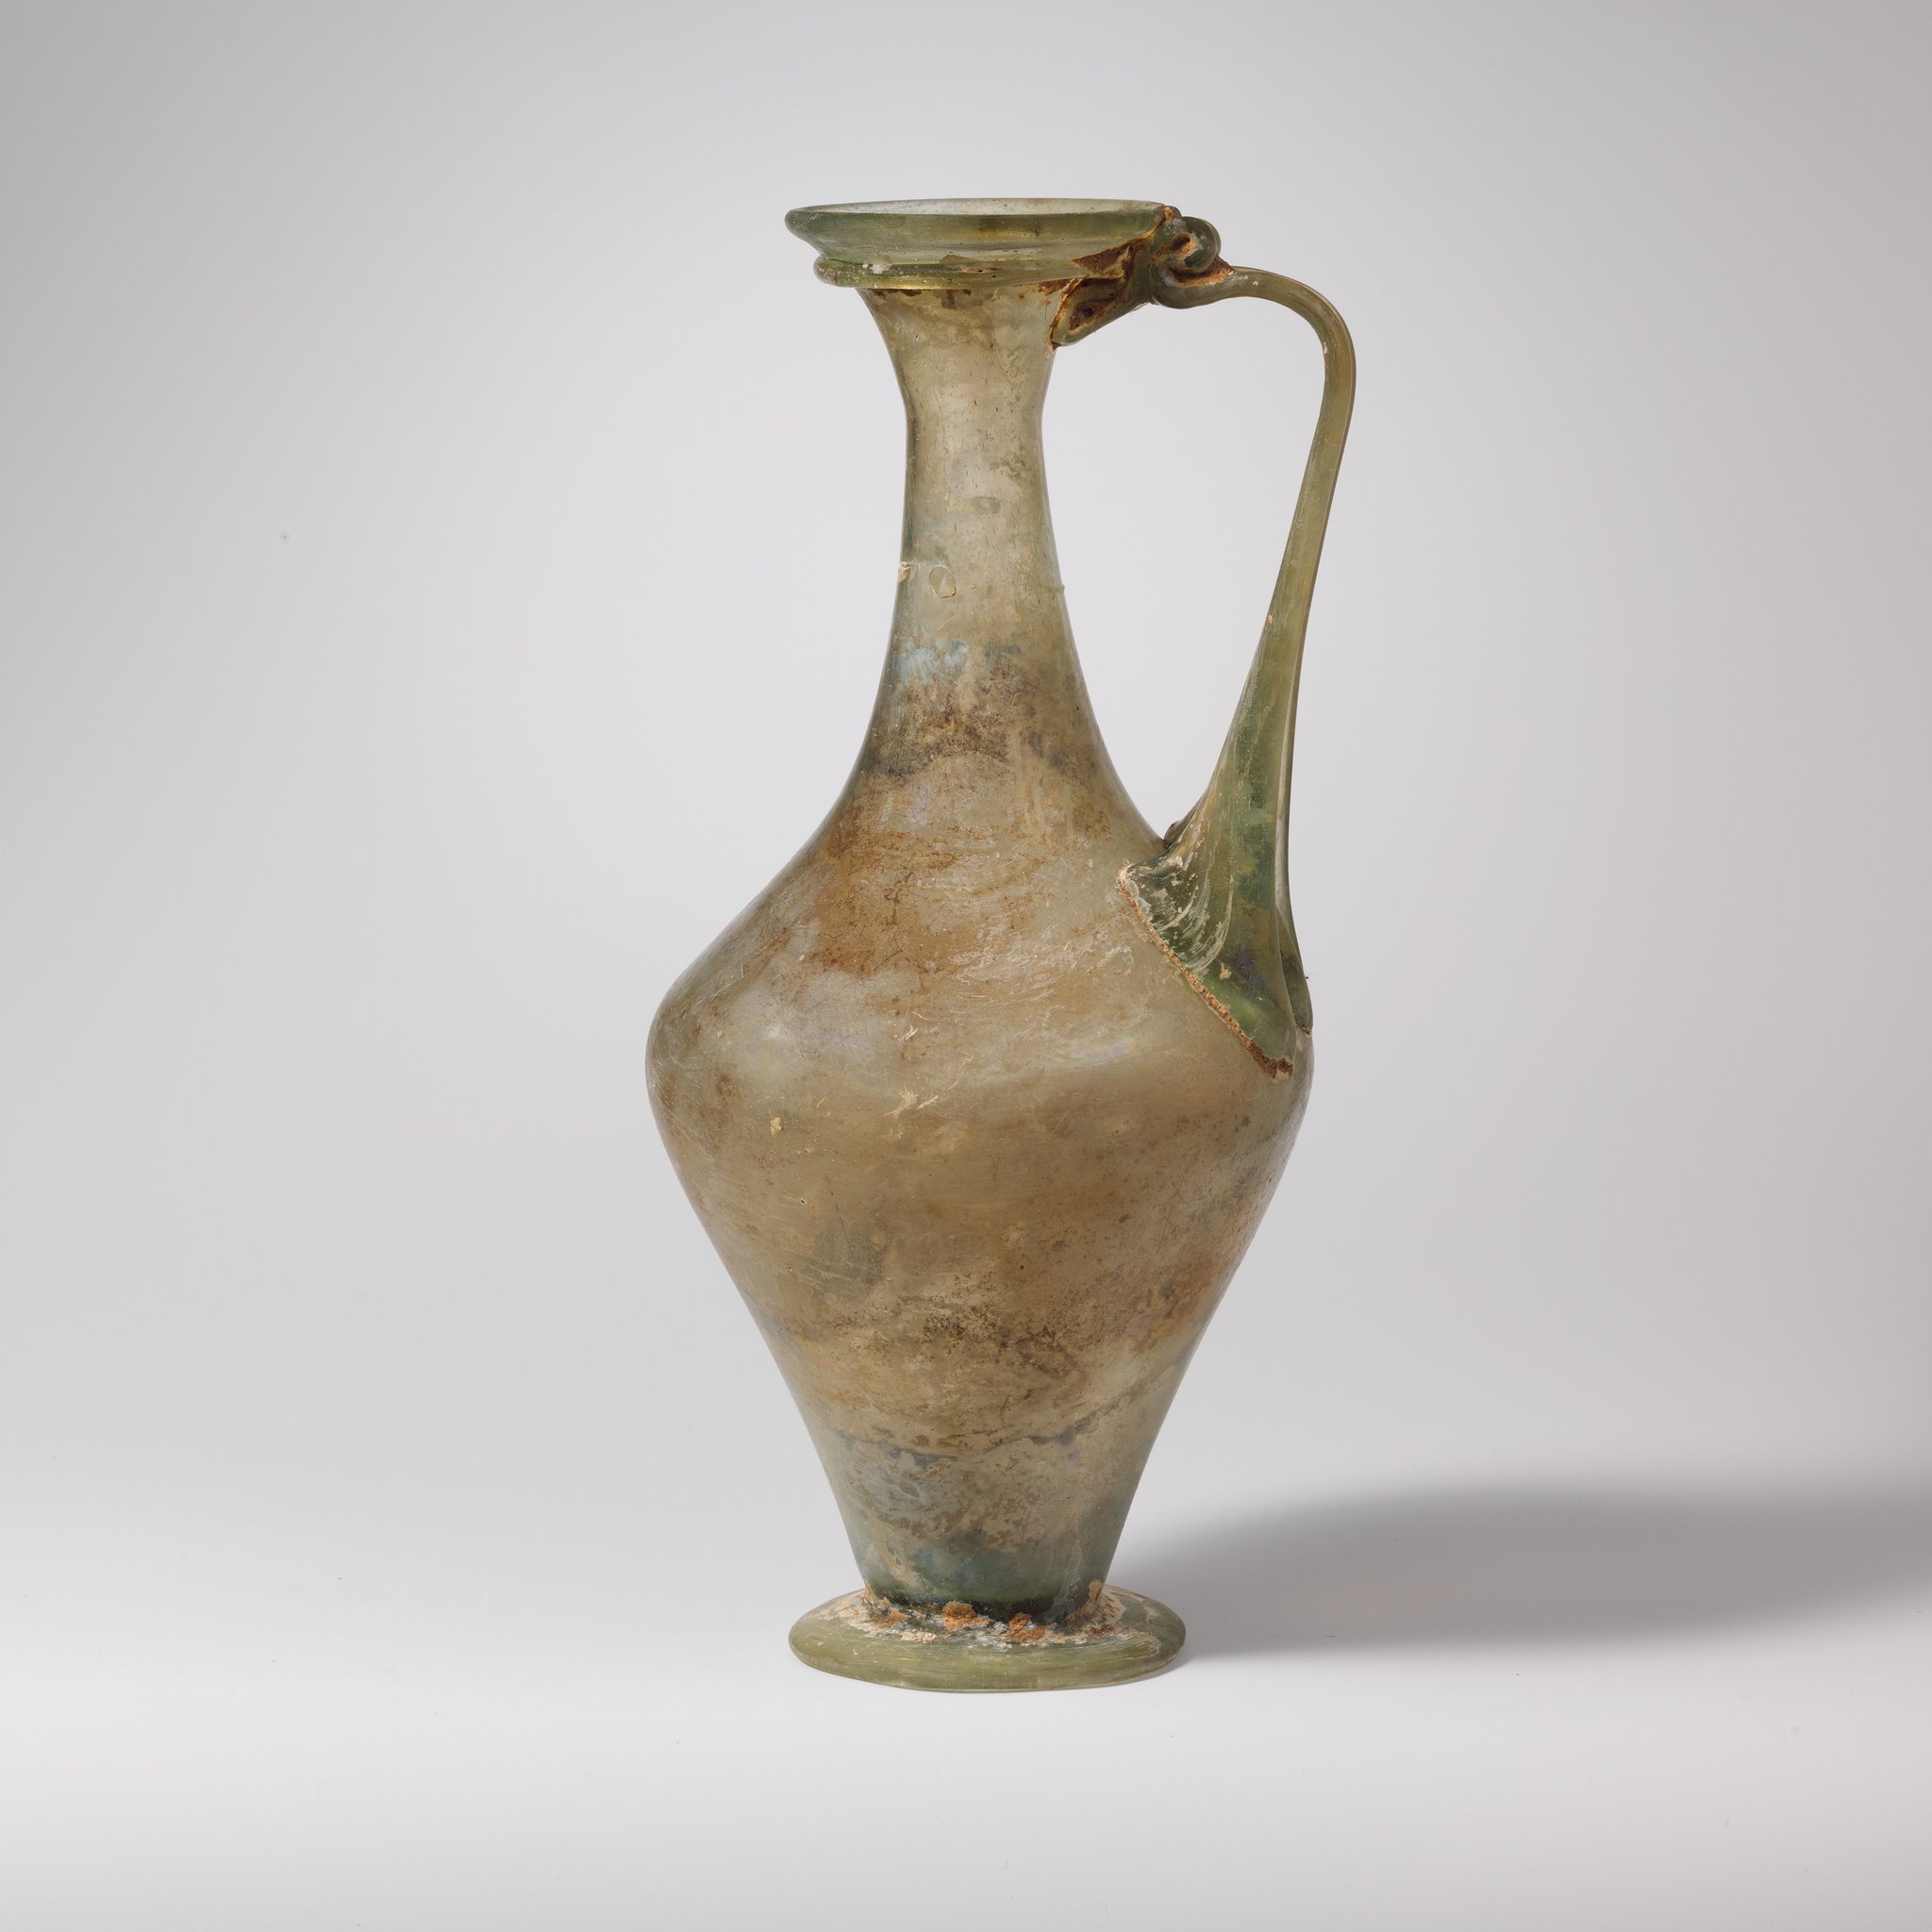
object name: jug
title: Glass jug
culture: roman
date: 334-366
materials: glass